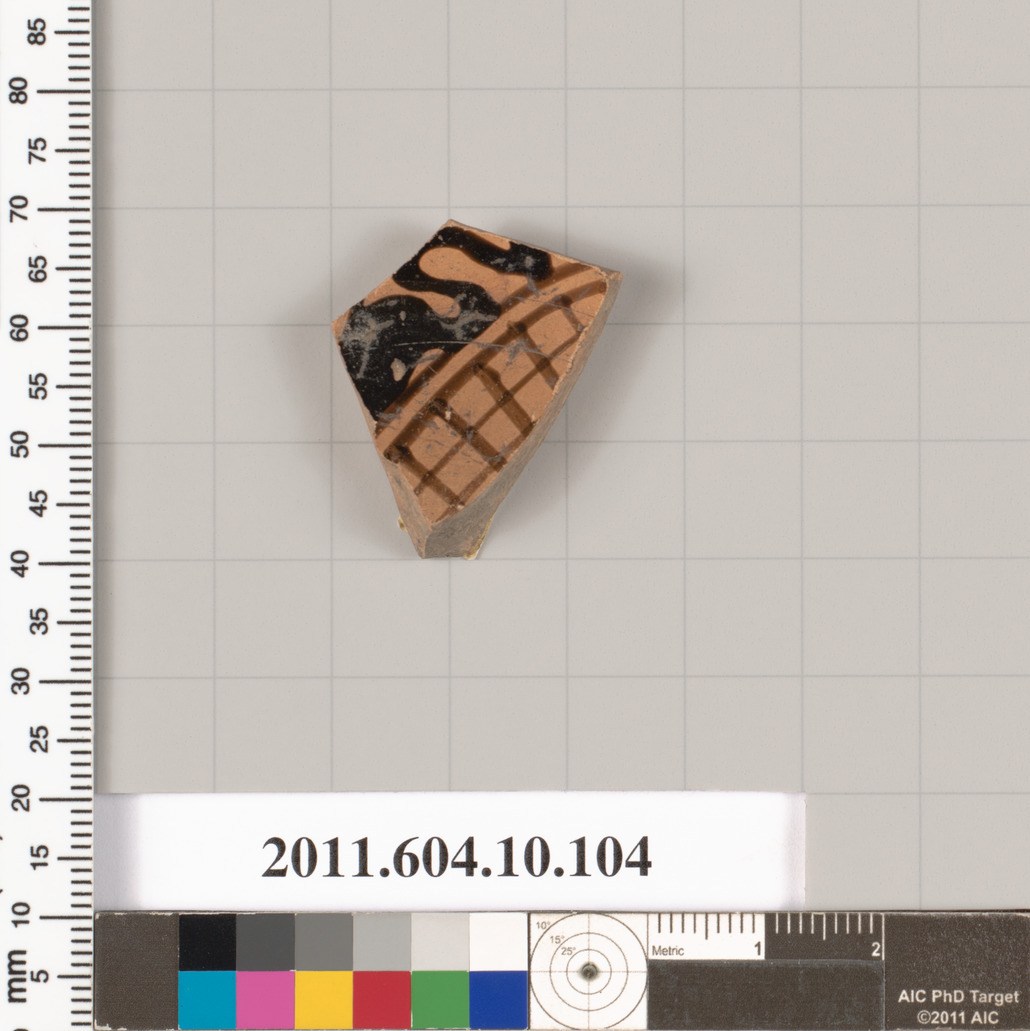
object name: genucilia plate fragment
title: Terracotta fragment of a Genucilia plate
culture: etruscan, genucilia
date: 367-335 BCE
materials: terracotta